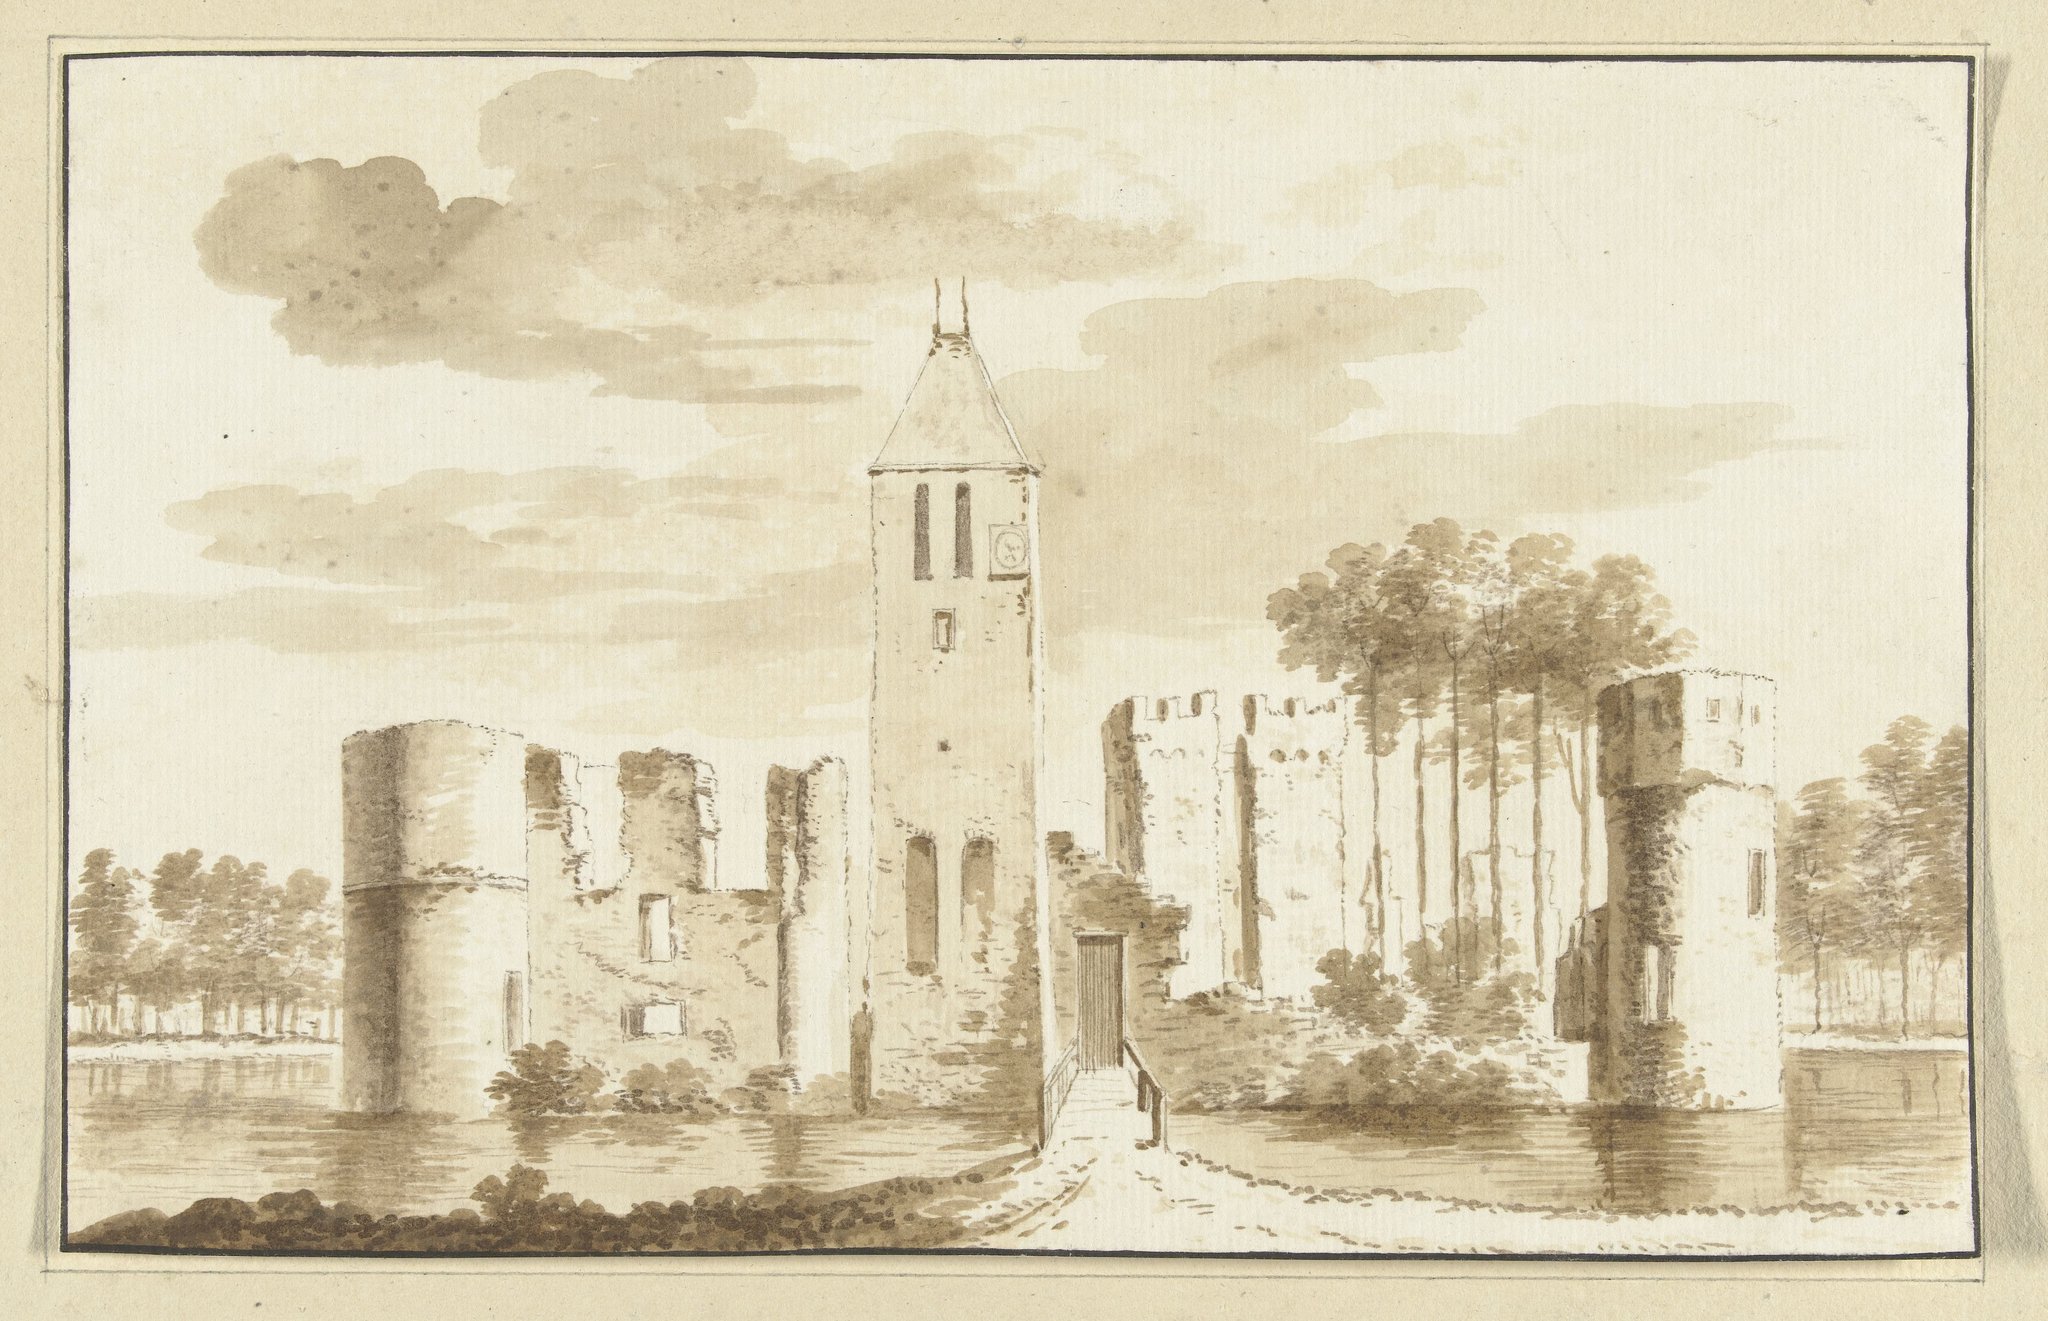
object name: drawing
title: Ruïne van kasteel te Egmond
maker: abraham rademaker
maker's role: draughtsman, print maker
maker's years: 1676-1735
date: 1685-1735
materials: paper, pencil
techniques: brush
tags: castle, ruin of a building ~ architecture